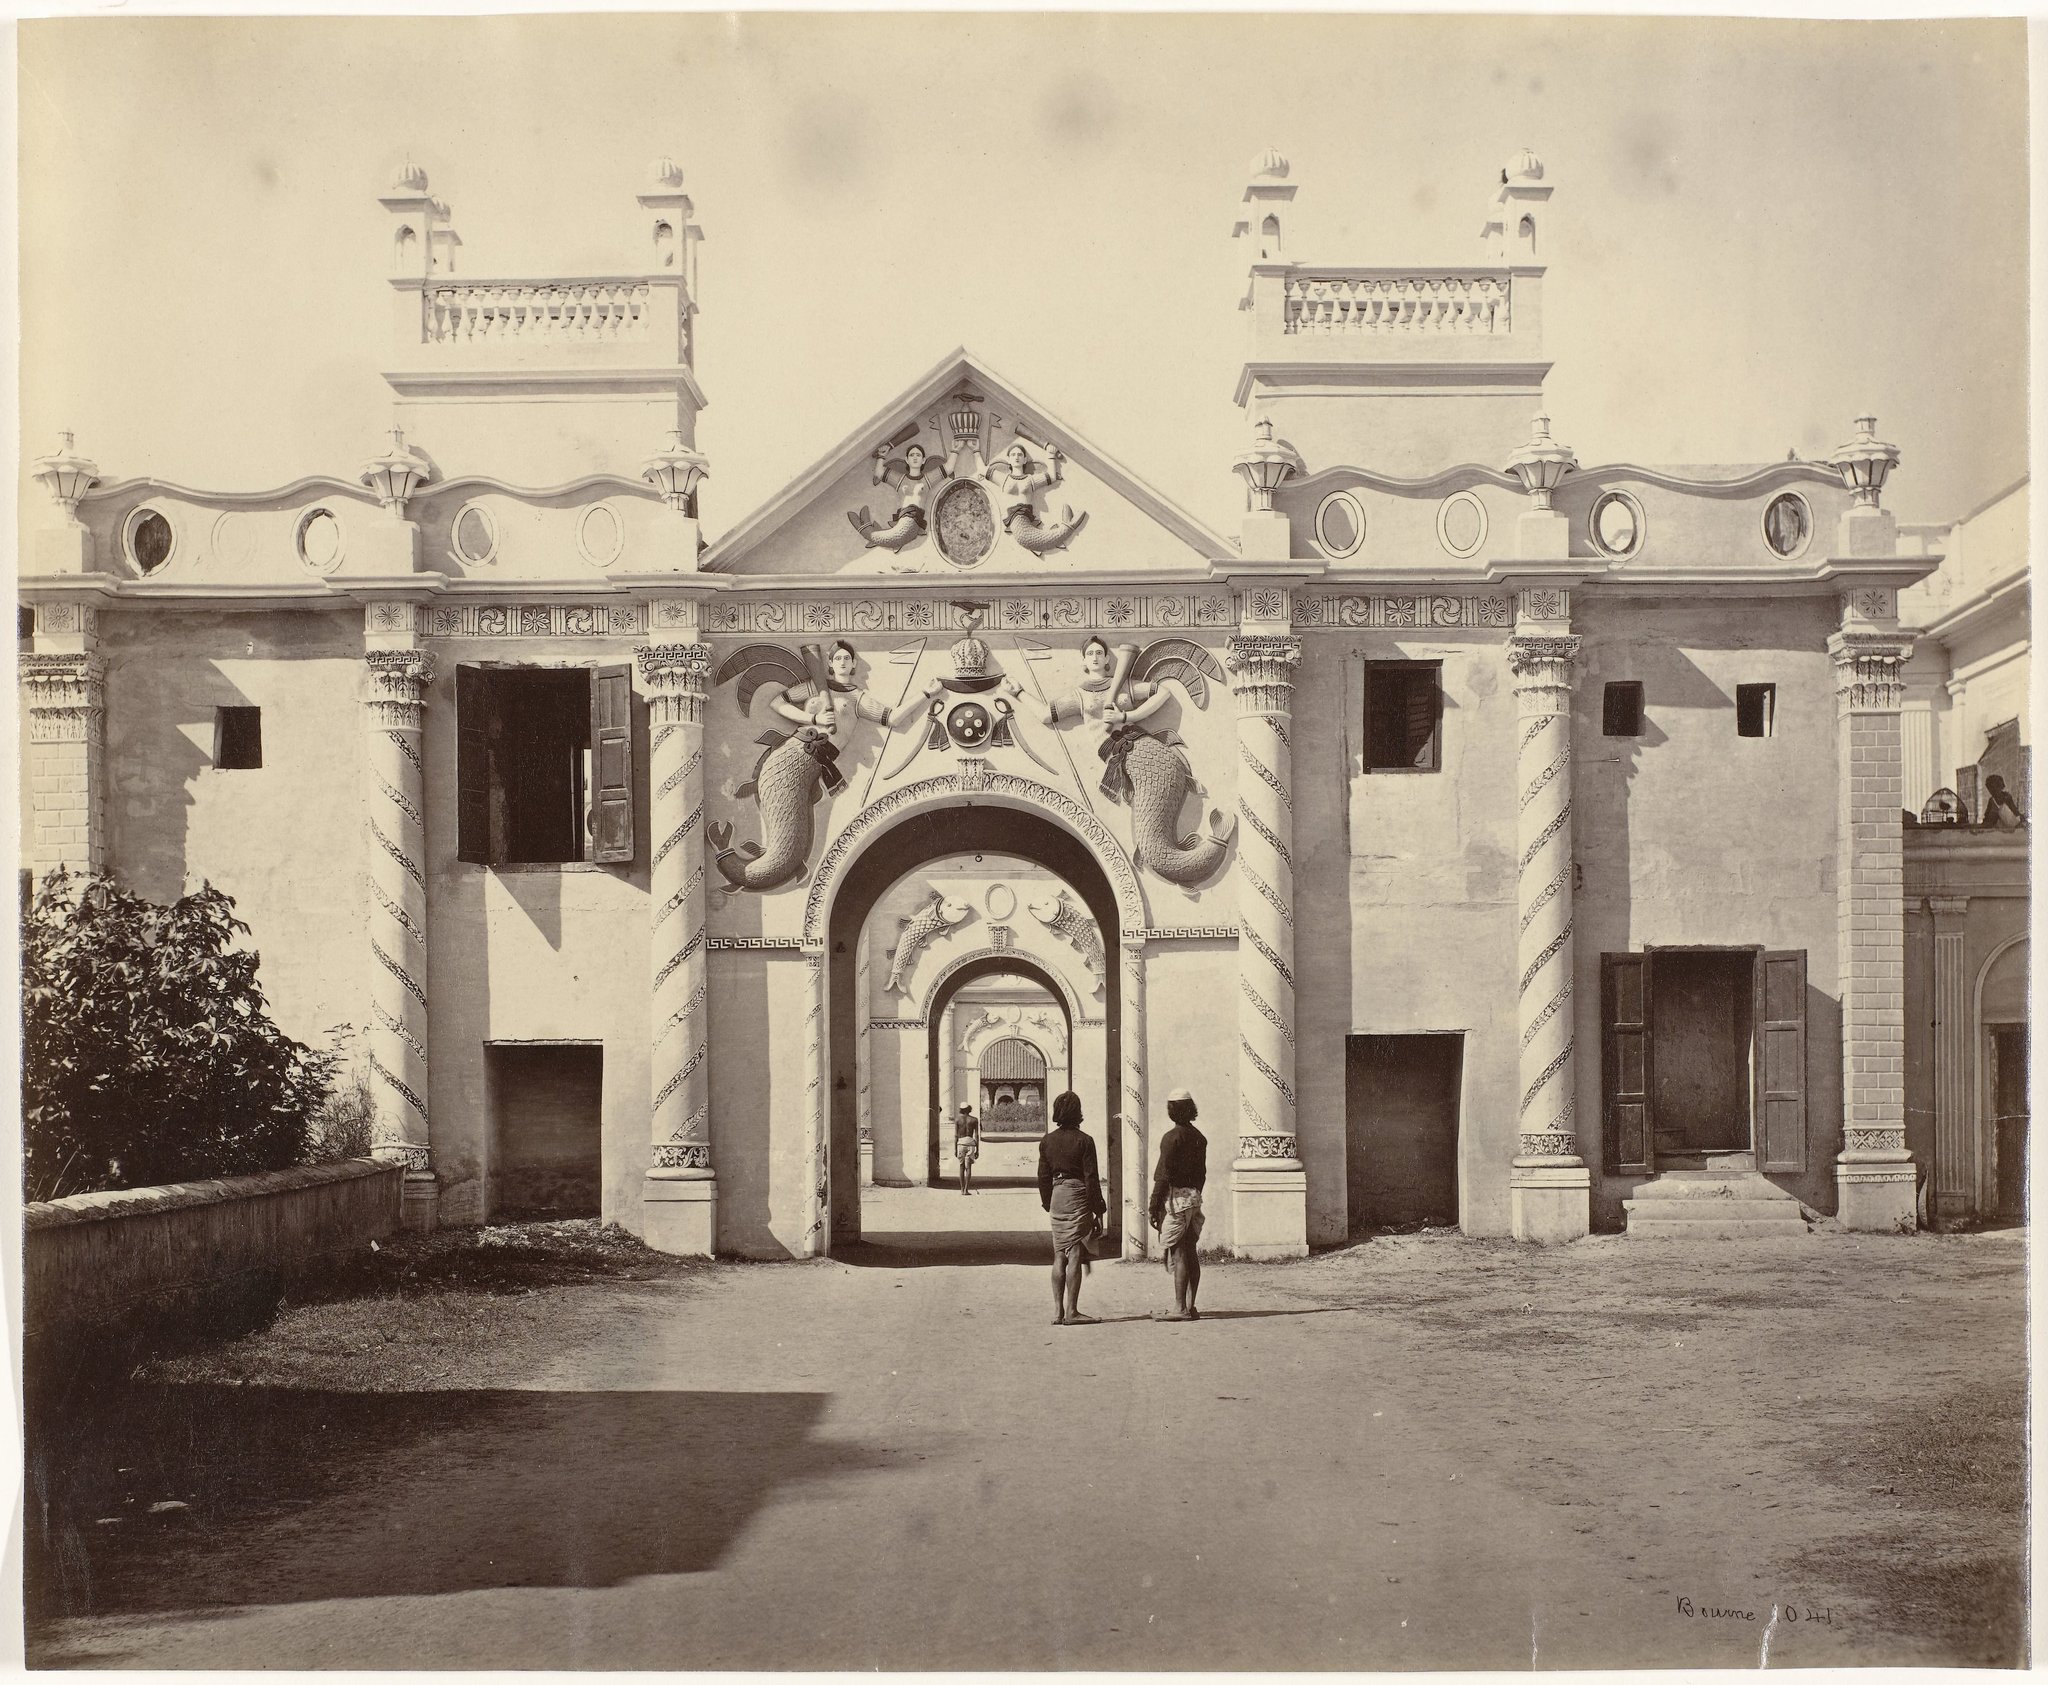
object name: photograph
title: Entrance gate with mermaids at the Lakhi Darwaza of Qaisar Bagh in Lucknow, Uttar Pradesh, India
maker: samuel bourne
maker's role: fotograaf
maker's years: 1834-1912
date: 1863-1865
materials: paper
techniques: albumen print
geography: lucknow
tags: merman - aa - mermaid, siren, gate, entrance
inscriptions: number: ‘1041’, number: ‘1041’, name: ‘Bourne’